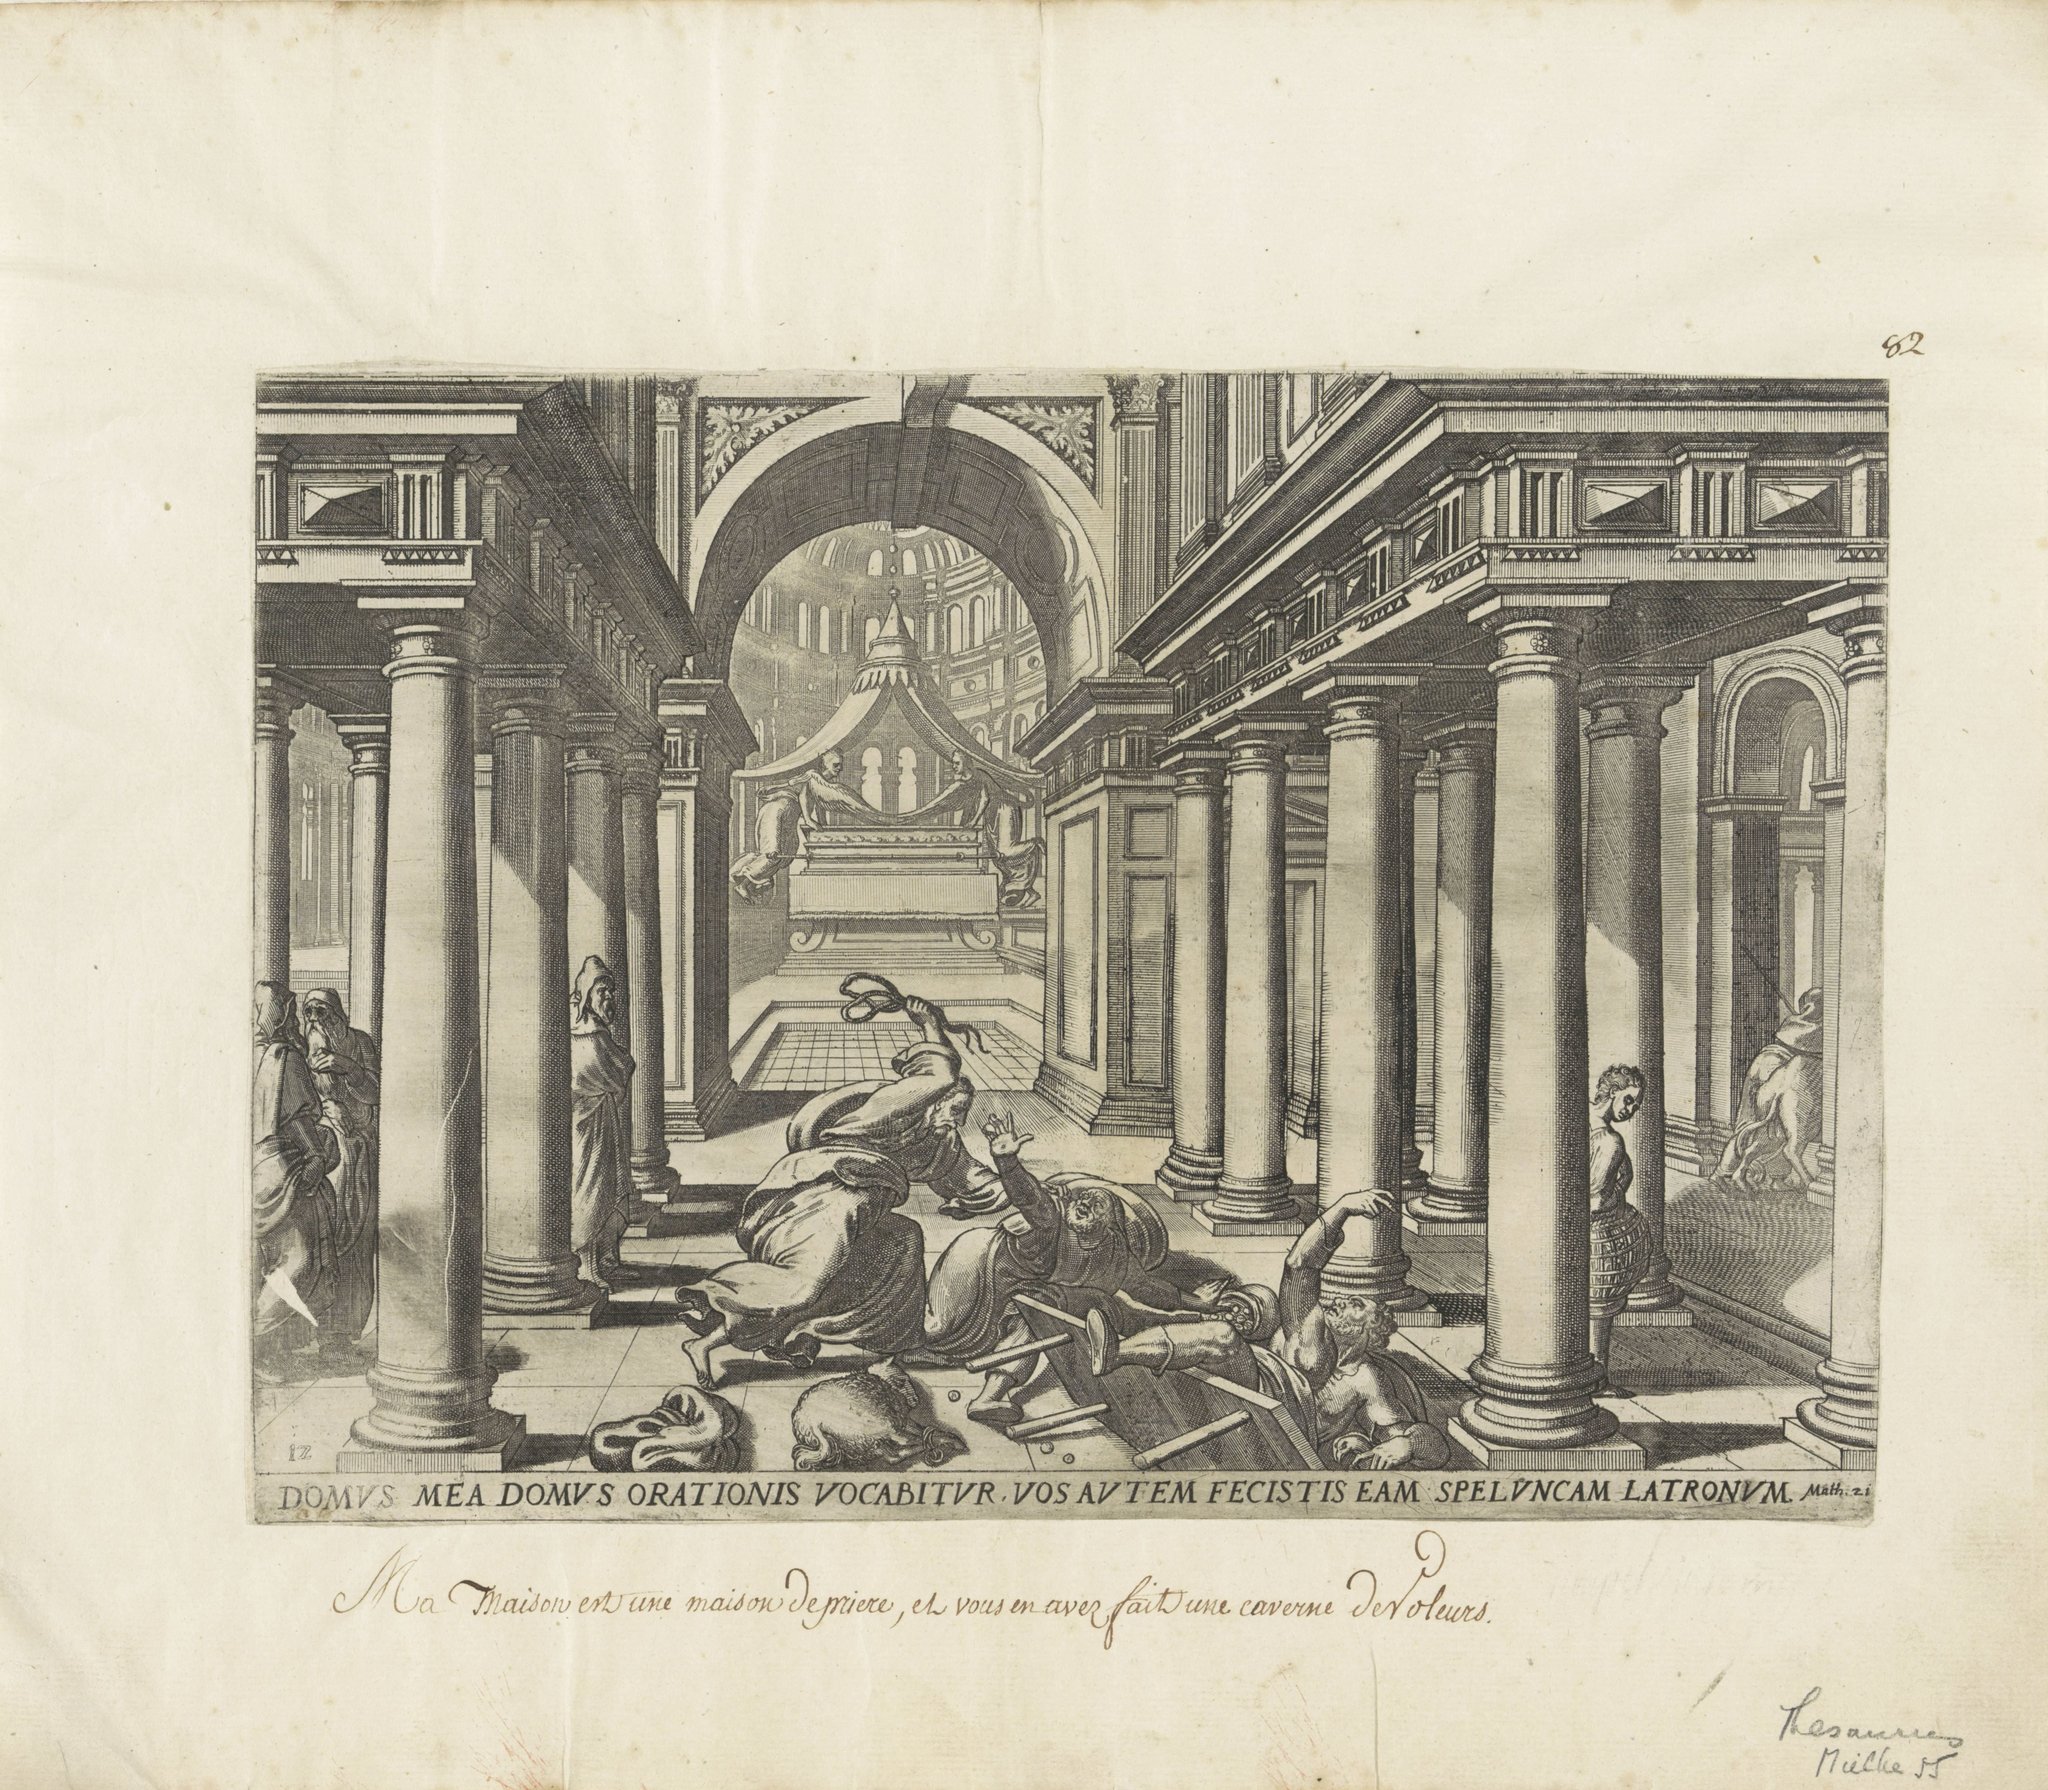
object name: print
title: Christus jaagt de geldwisselaars uit de tempel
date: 1585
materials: paper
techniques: engraving, etching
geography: antwerp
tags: purification of the temple ('first' and 'second'): christ driving the money-changers from the temple with a whip (matthew 21:12-13; mark 11:15-17; luke 19:45-46; john 12:12-19)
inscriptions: inscription: ‘Ma maison est une maison de priere, et vous en avez fait une caverne de Voleurs.’, collector's mark: Lugt 2228, number: ‘82’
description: Christus verdrijft met een zweep in de hand de geldwisselaars uit de tempel. Hij heeft hun tafel ongegooid. Op de achtergrond de Ark van het verbond. Onder de voorstelling een verwijzing in het Latijn naar de Bijbeltekst in Mat. 21.